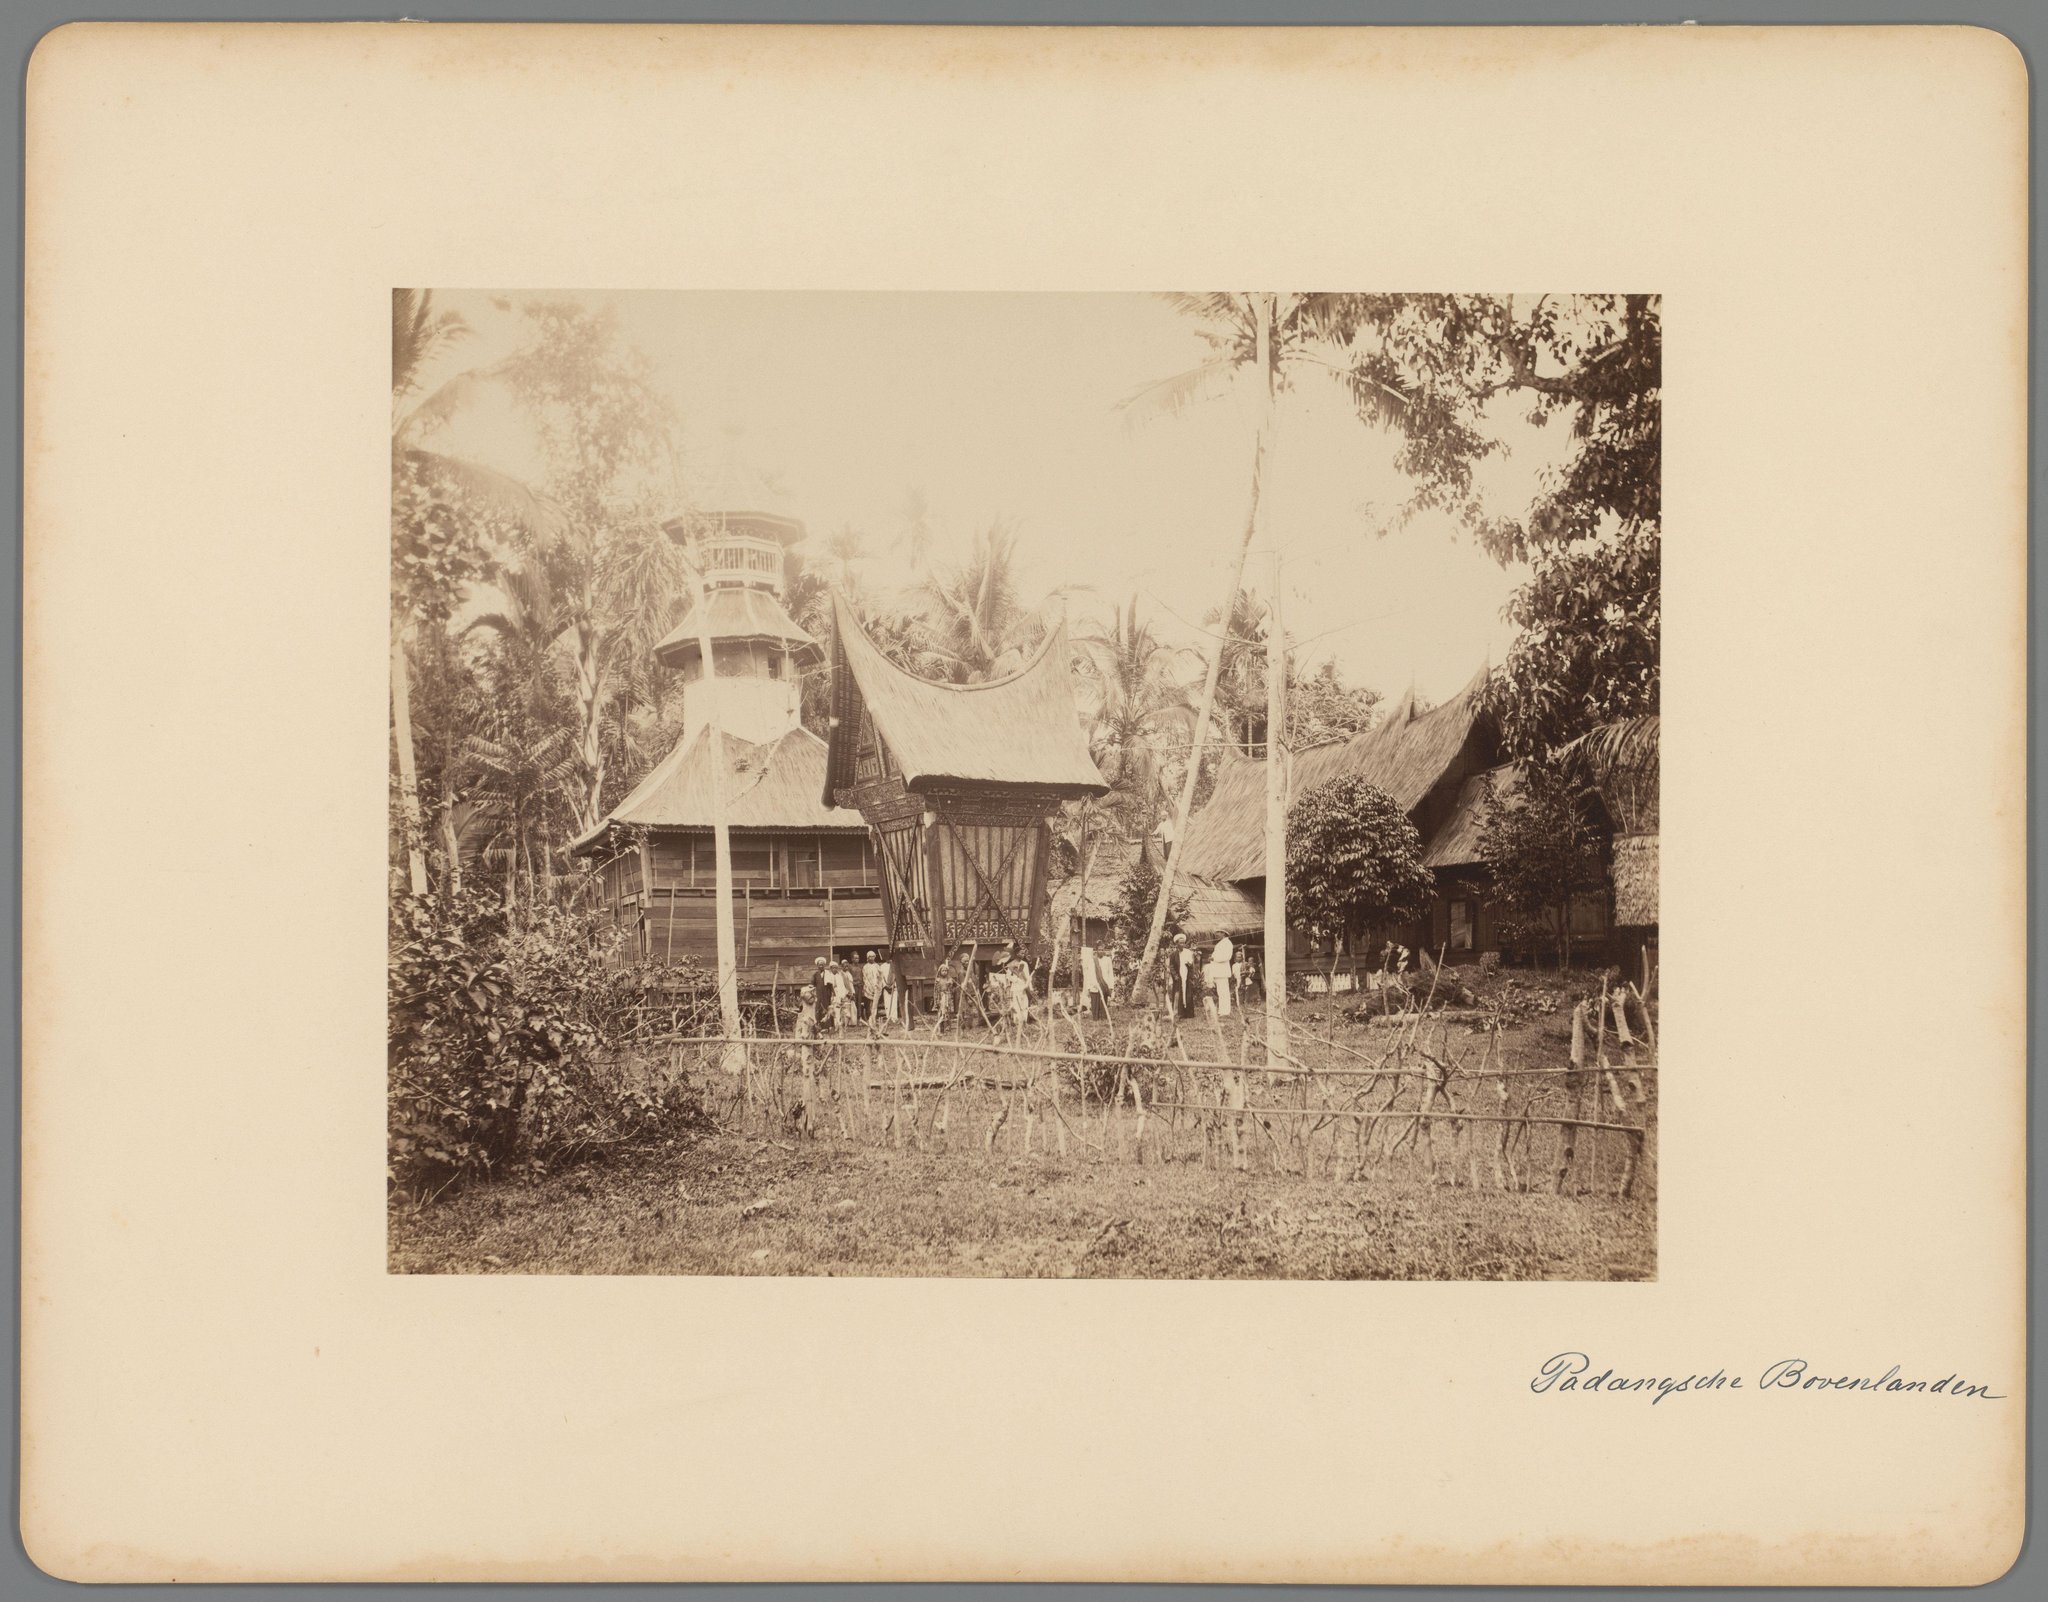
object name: photograph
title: Dorp in West-Sumatra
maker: christiaan benjamin nieuwenhuis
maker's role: publisher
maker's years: 1863-1922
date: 1891-1895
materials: cardboard, paper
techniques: albumen print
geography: sumatera barat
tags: prospect of village, silhouette of village, sumatera barat (province)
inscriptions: inscription: ‘Foto’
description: Deze foto zat oorspronkelijk in prentenkabinet RP-F-AA3192.